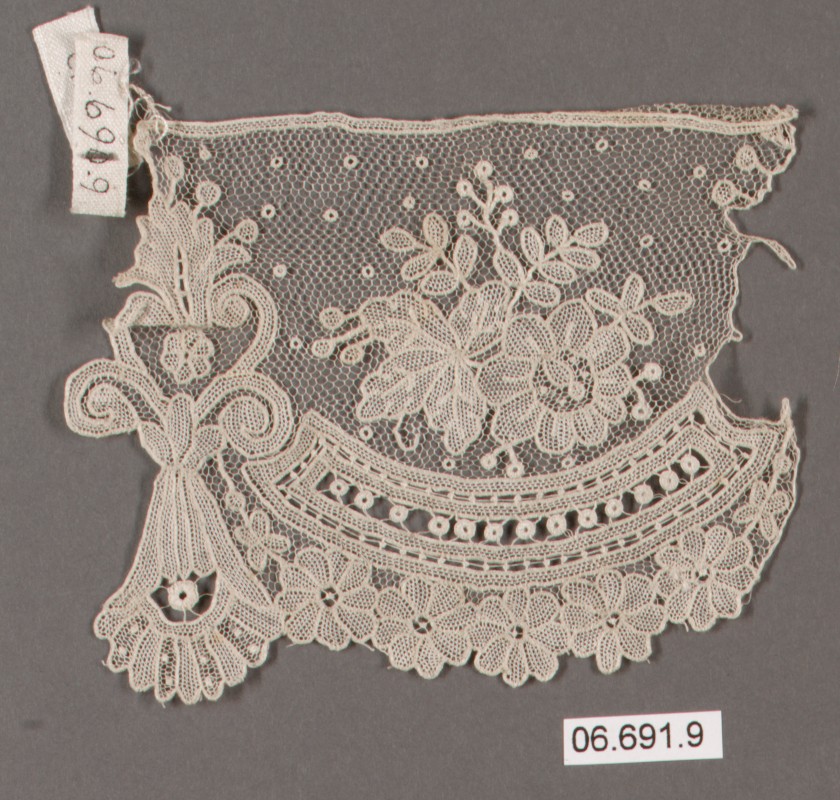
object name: fragment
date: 1801-1900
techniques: lace